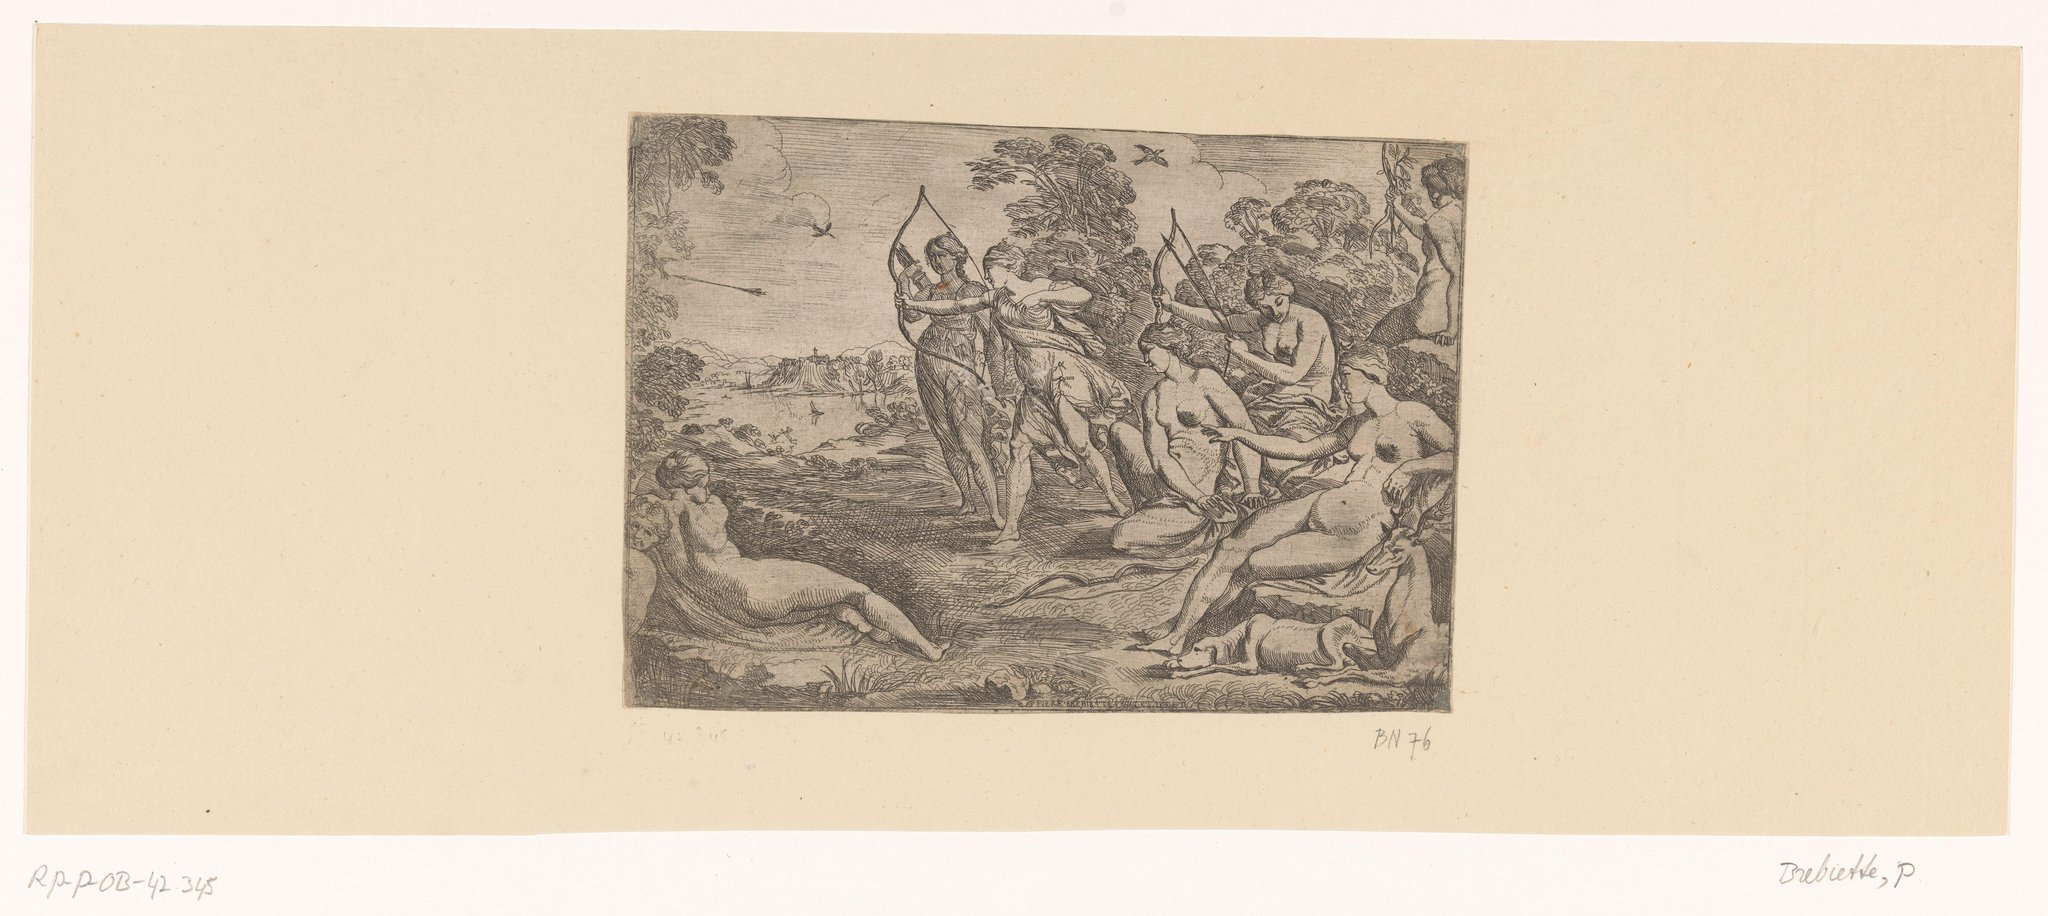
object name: print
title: Diana op jacht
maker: pierre brebiette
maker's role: draughtsman, print maker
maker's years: 1598-1650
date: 1608-1650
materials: paper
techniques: etching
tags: diana hunting with her nymphs, shooting with bow and arrow, archery (~ games of skill)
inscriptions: collector's mark: Lugt 240